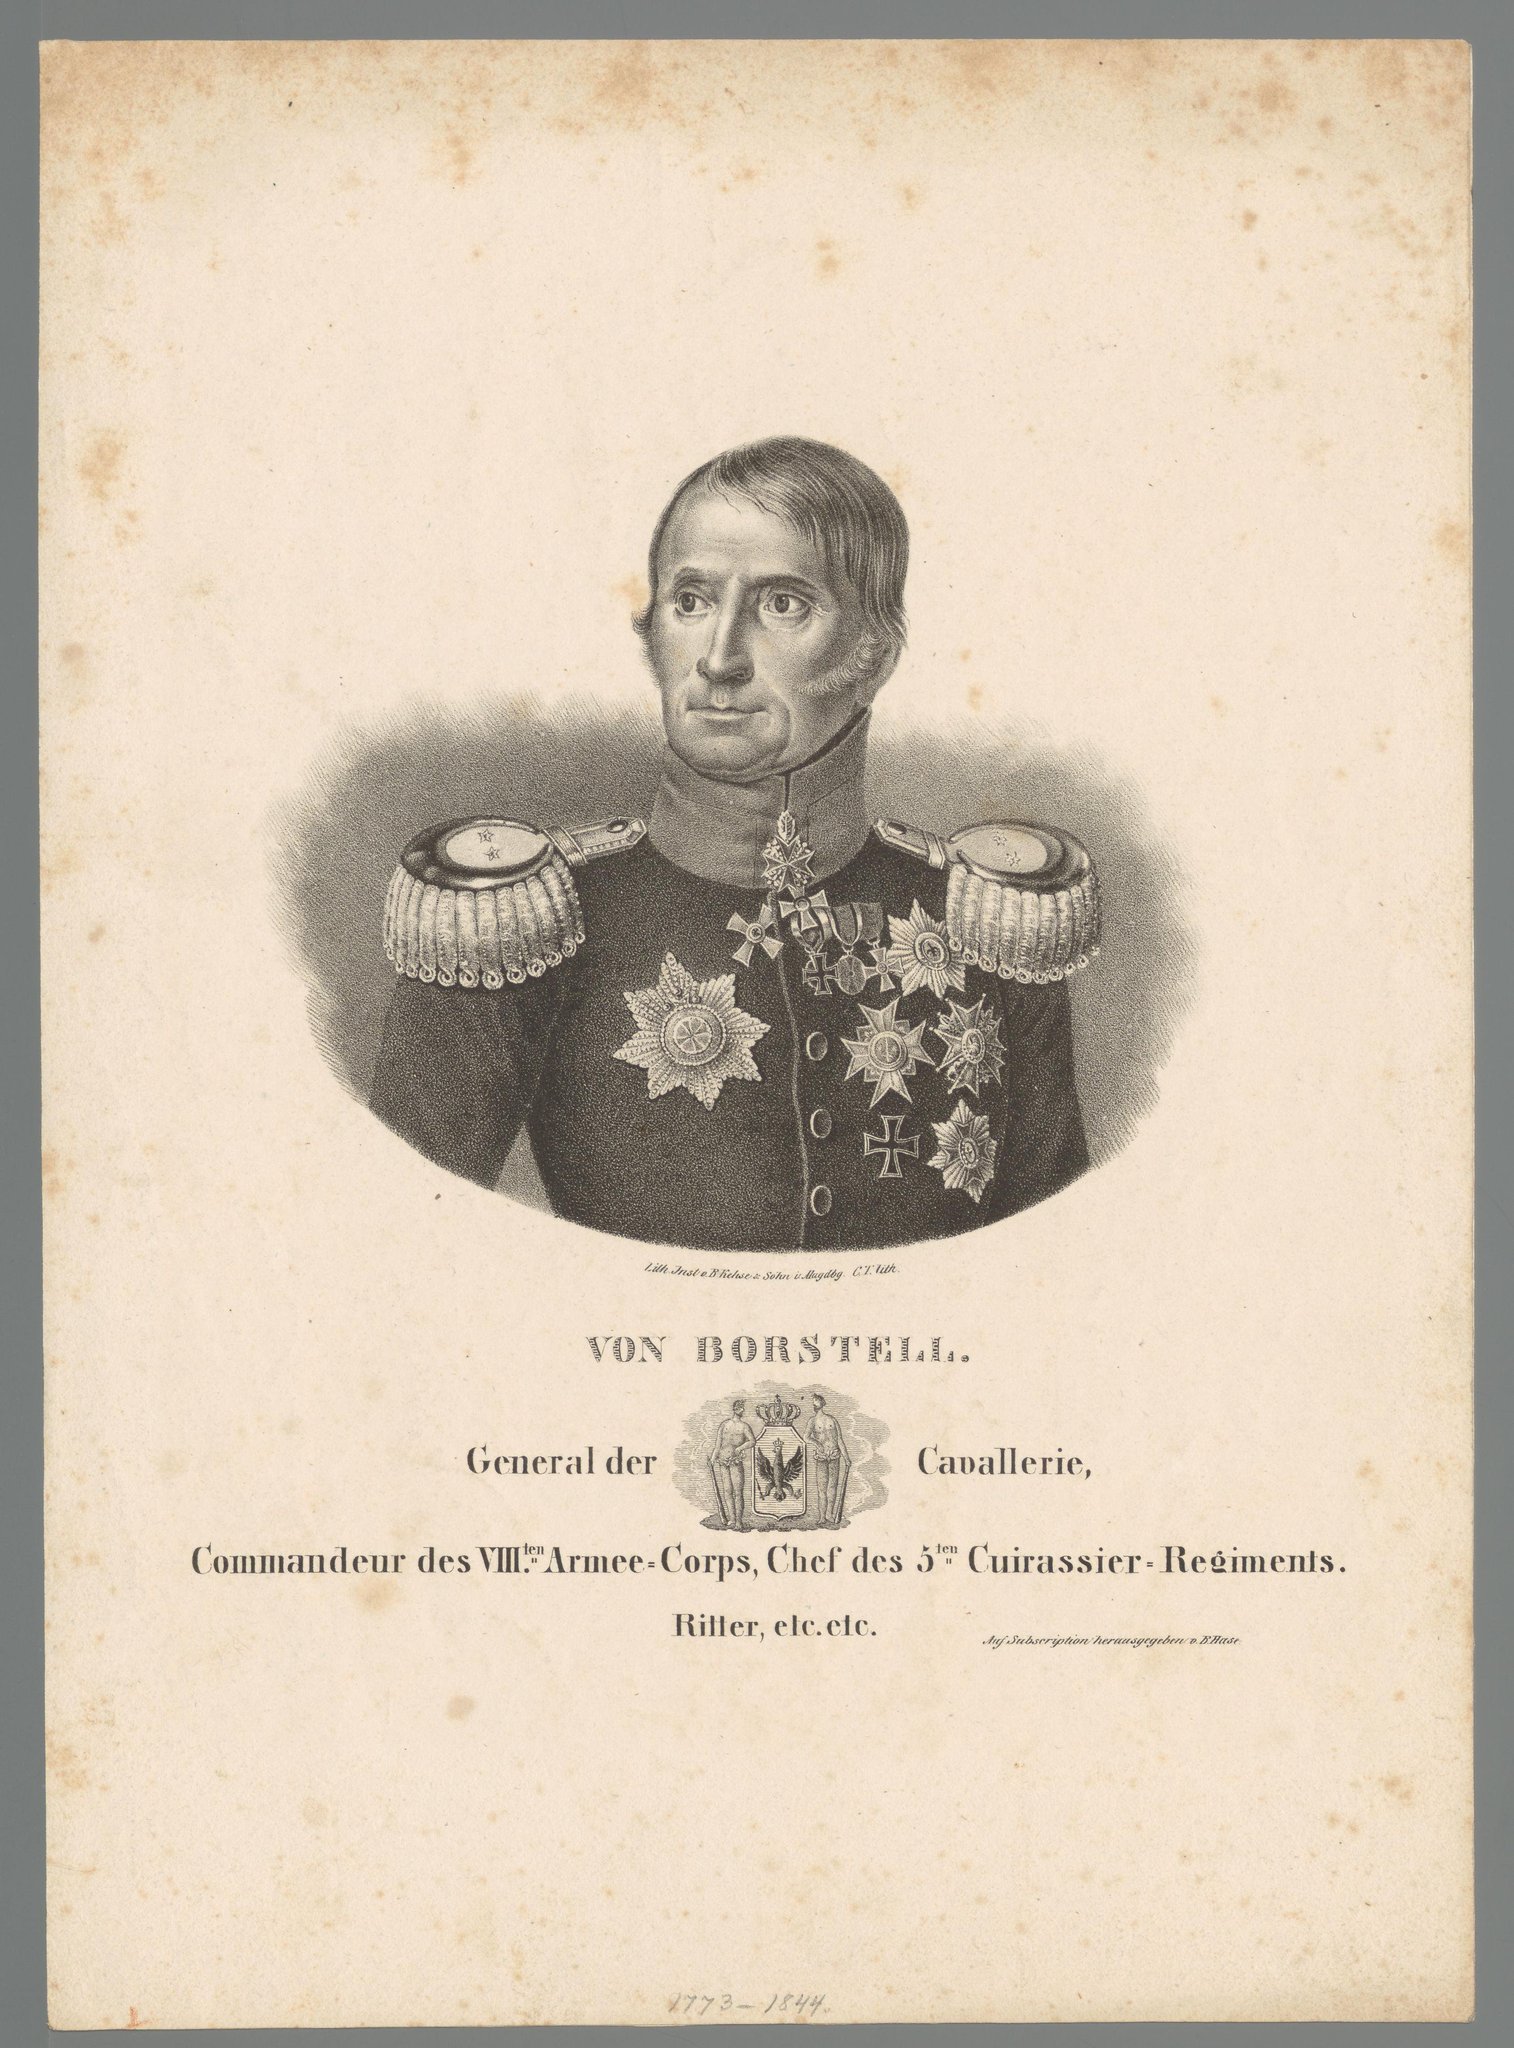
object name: print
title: Von Borstell, General der Cavallerie (...) Ritter etc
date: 1830-1850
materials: paper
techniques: lithograph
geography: magdeburg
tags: adult man, historical persons, (military) uniforms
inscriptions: collector's mark: Lugt 2228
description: Midden onder staat het wapen van Pruisen.